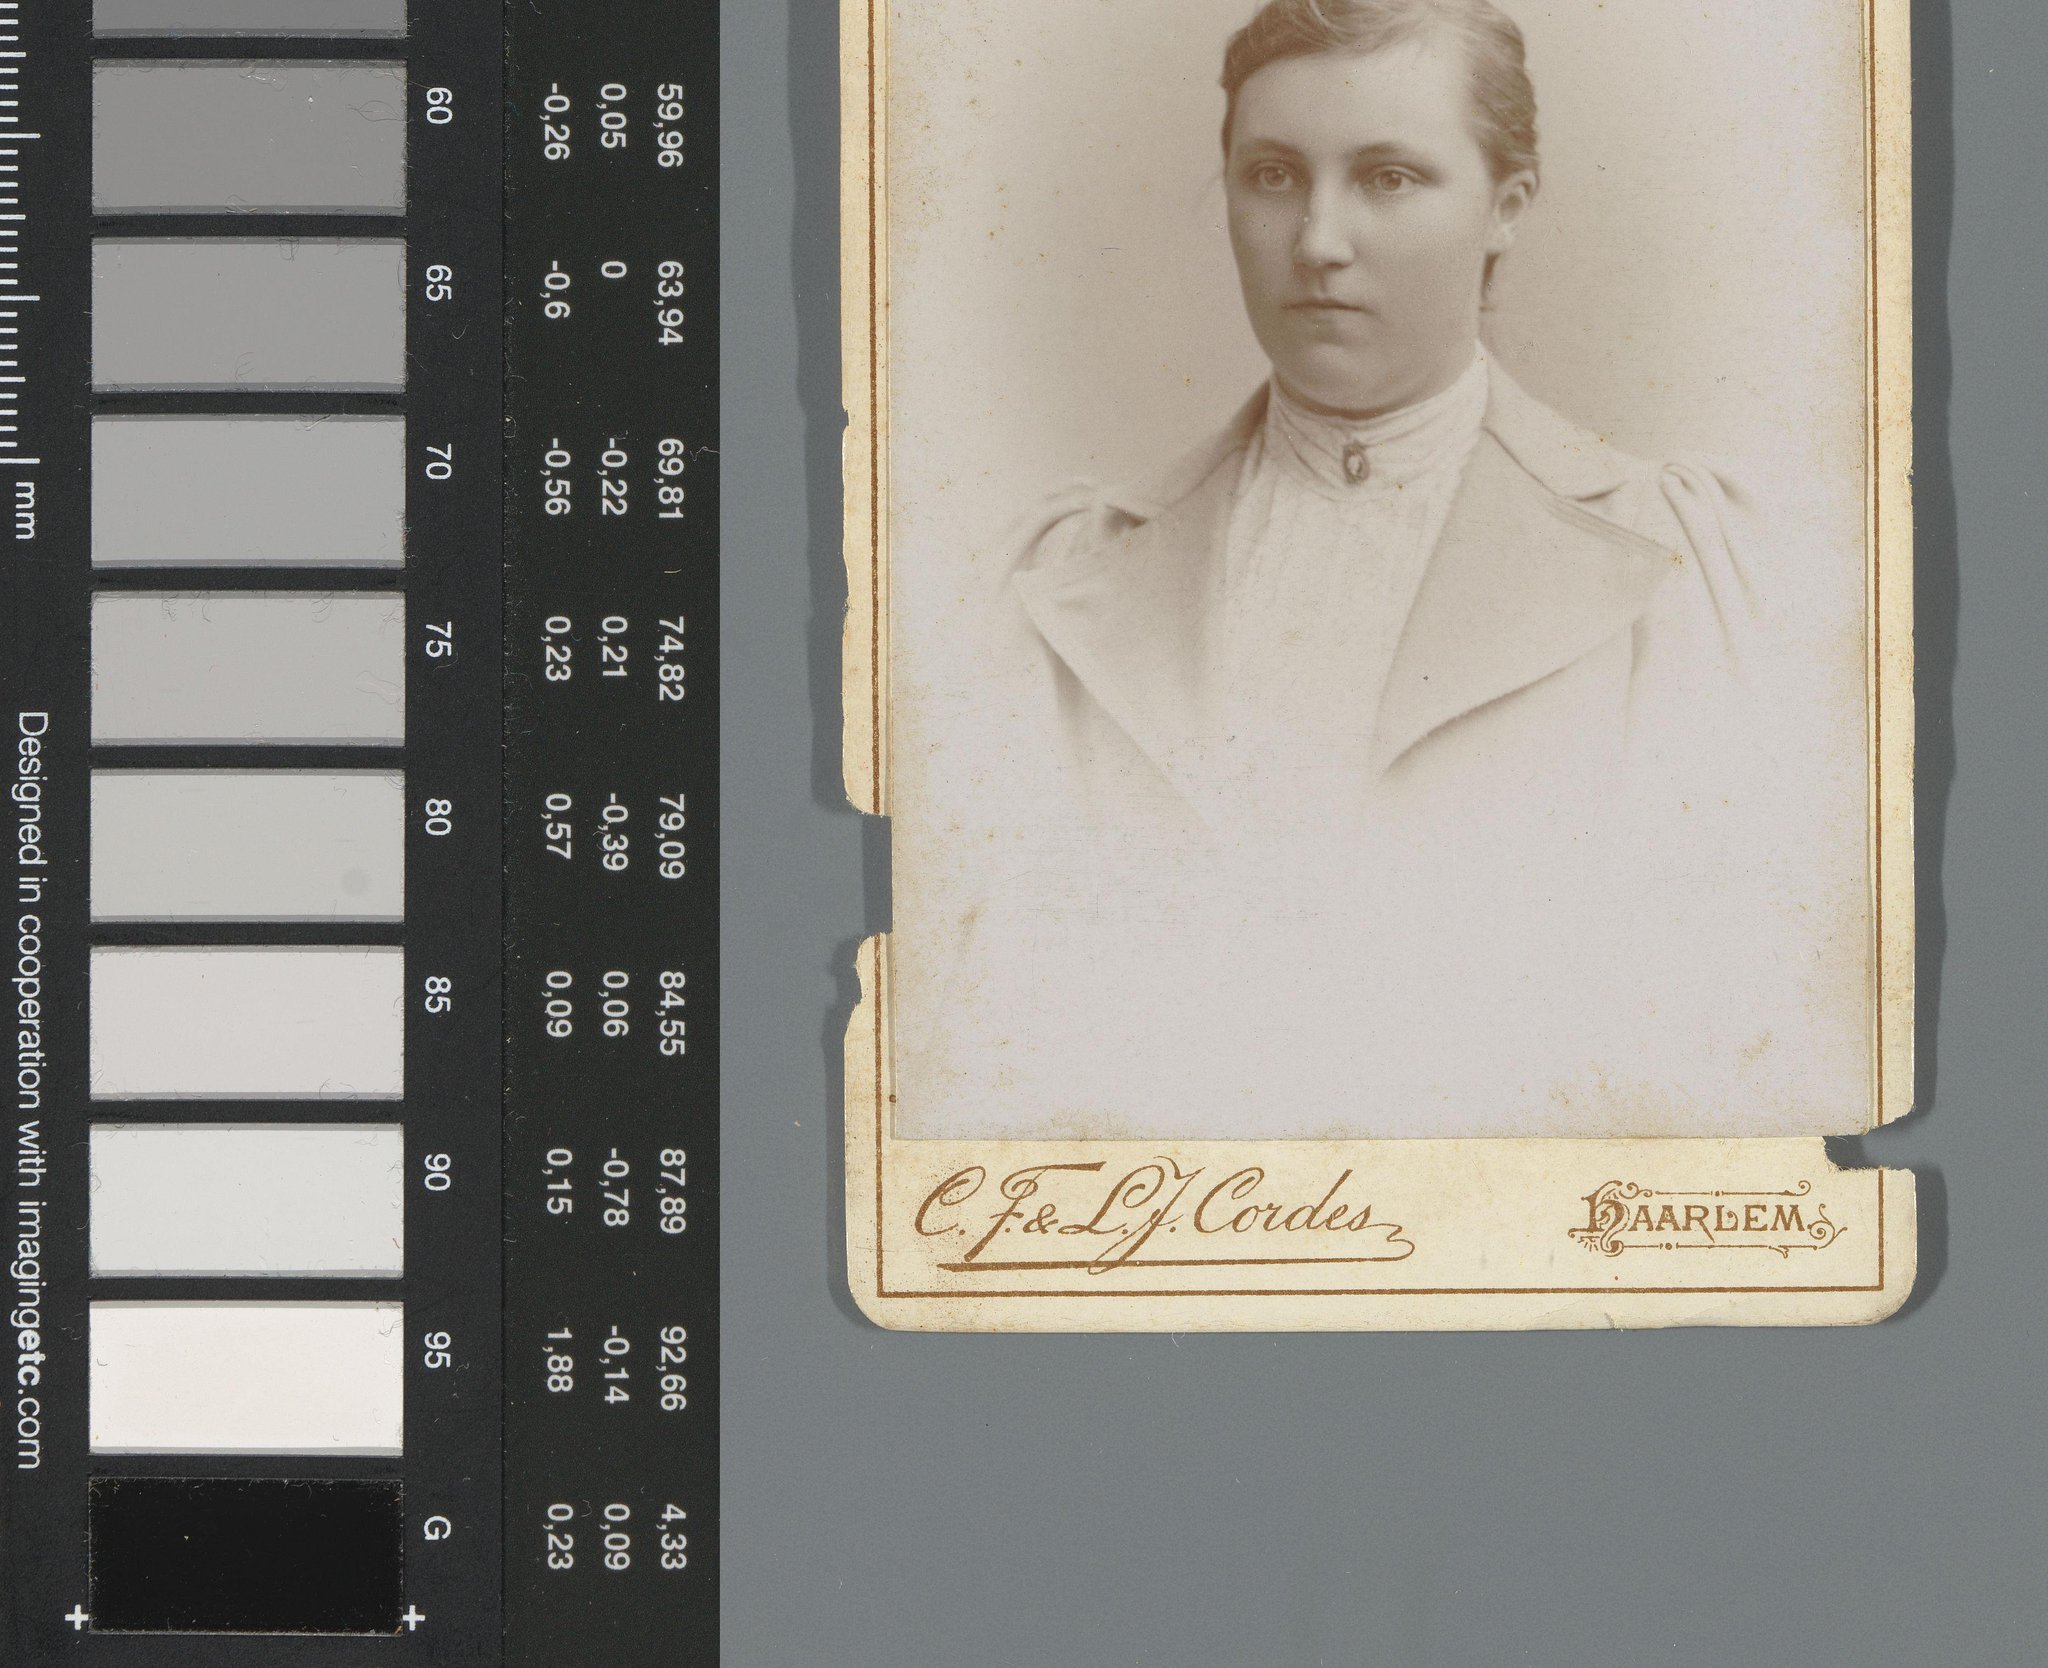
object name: carte de visite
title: Portret van Goverta de Clercq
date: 1892-1900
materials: cardboard, photographic support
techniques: photography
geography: haarlem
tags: historical persons - bb - woman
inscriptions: annotation: ‘G. Hylkema-de Clercq’